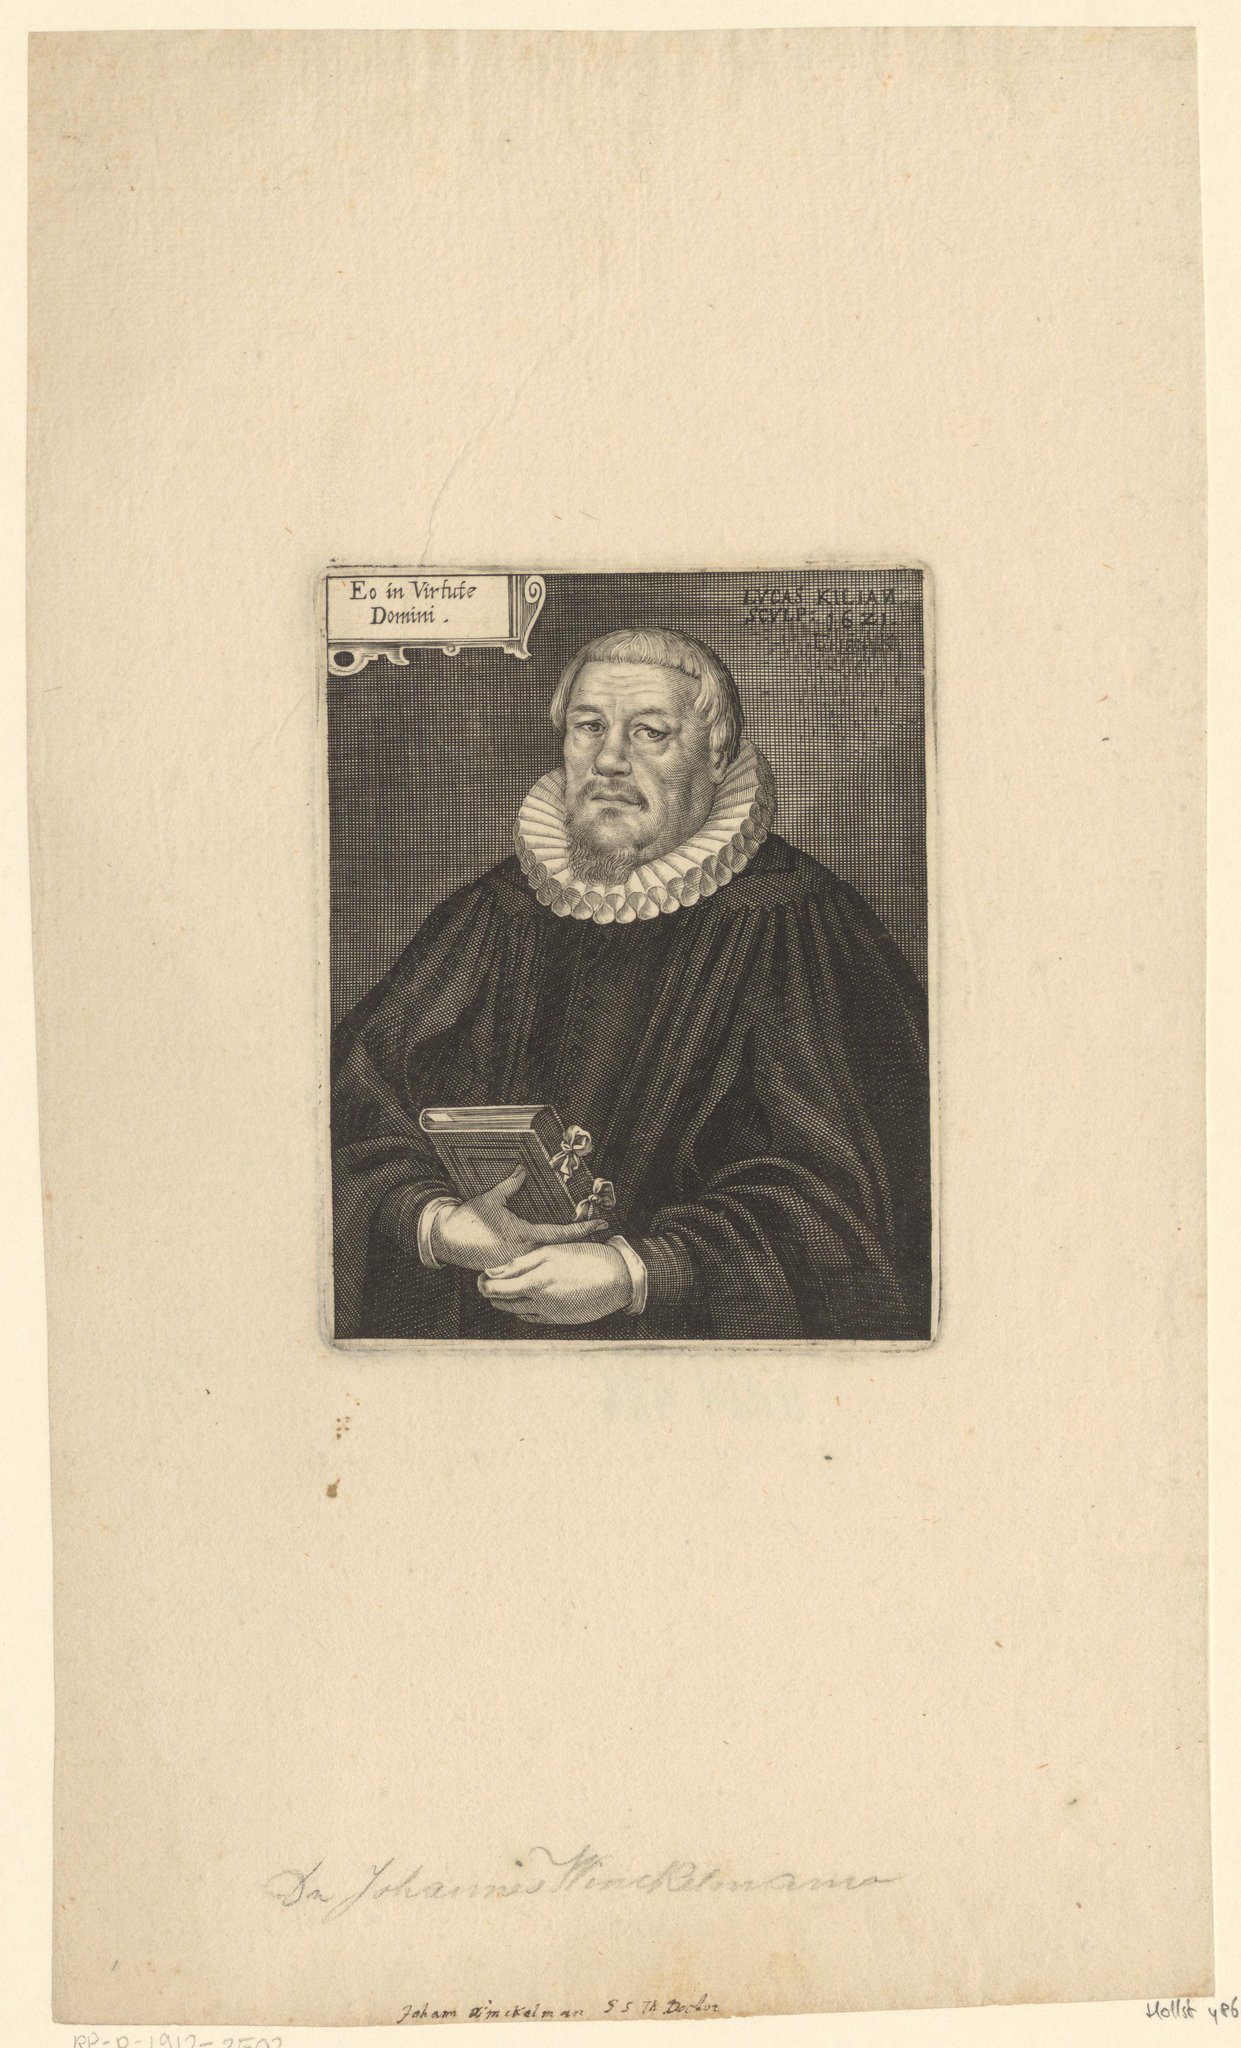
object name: print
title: Portret van Johann Winckelmann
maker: lucas kilian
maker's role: draughtsman, print maker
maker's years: 1579-1637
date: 1621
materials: paper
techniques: engraving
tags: theologian, historical persons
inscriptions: collector's mark: Lugt 2228